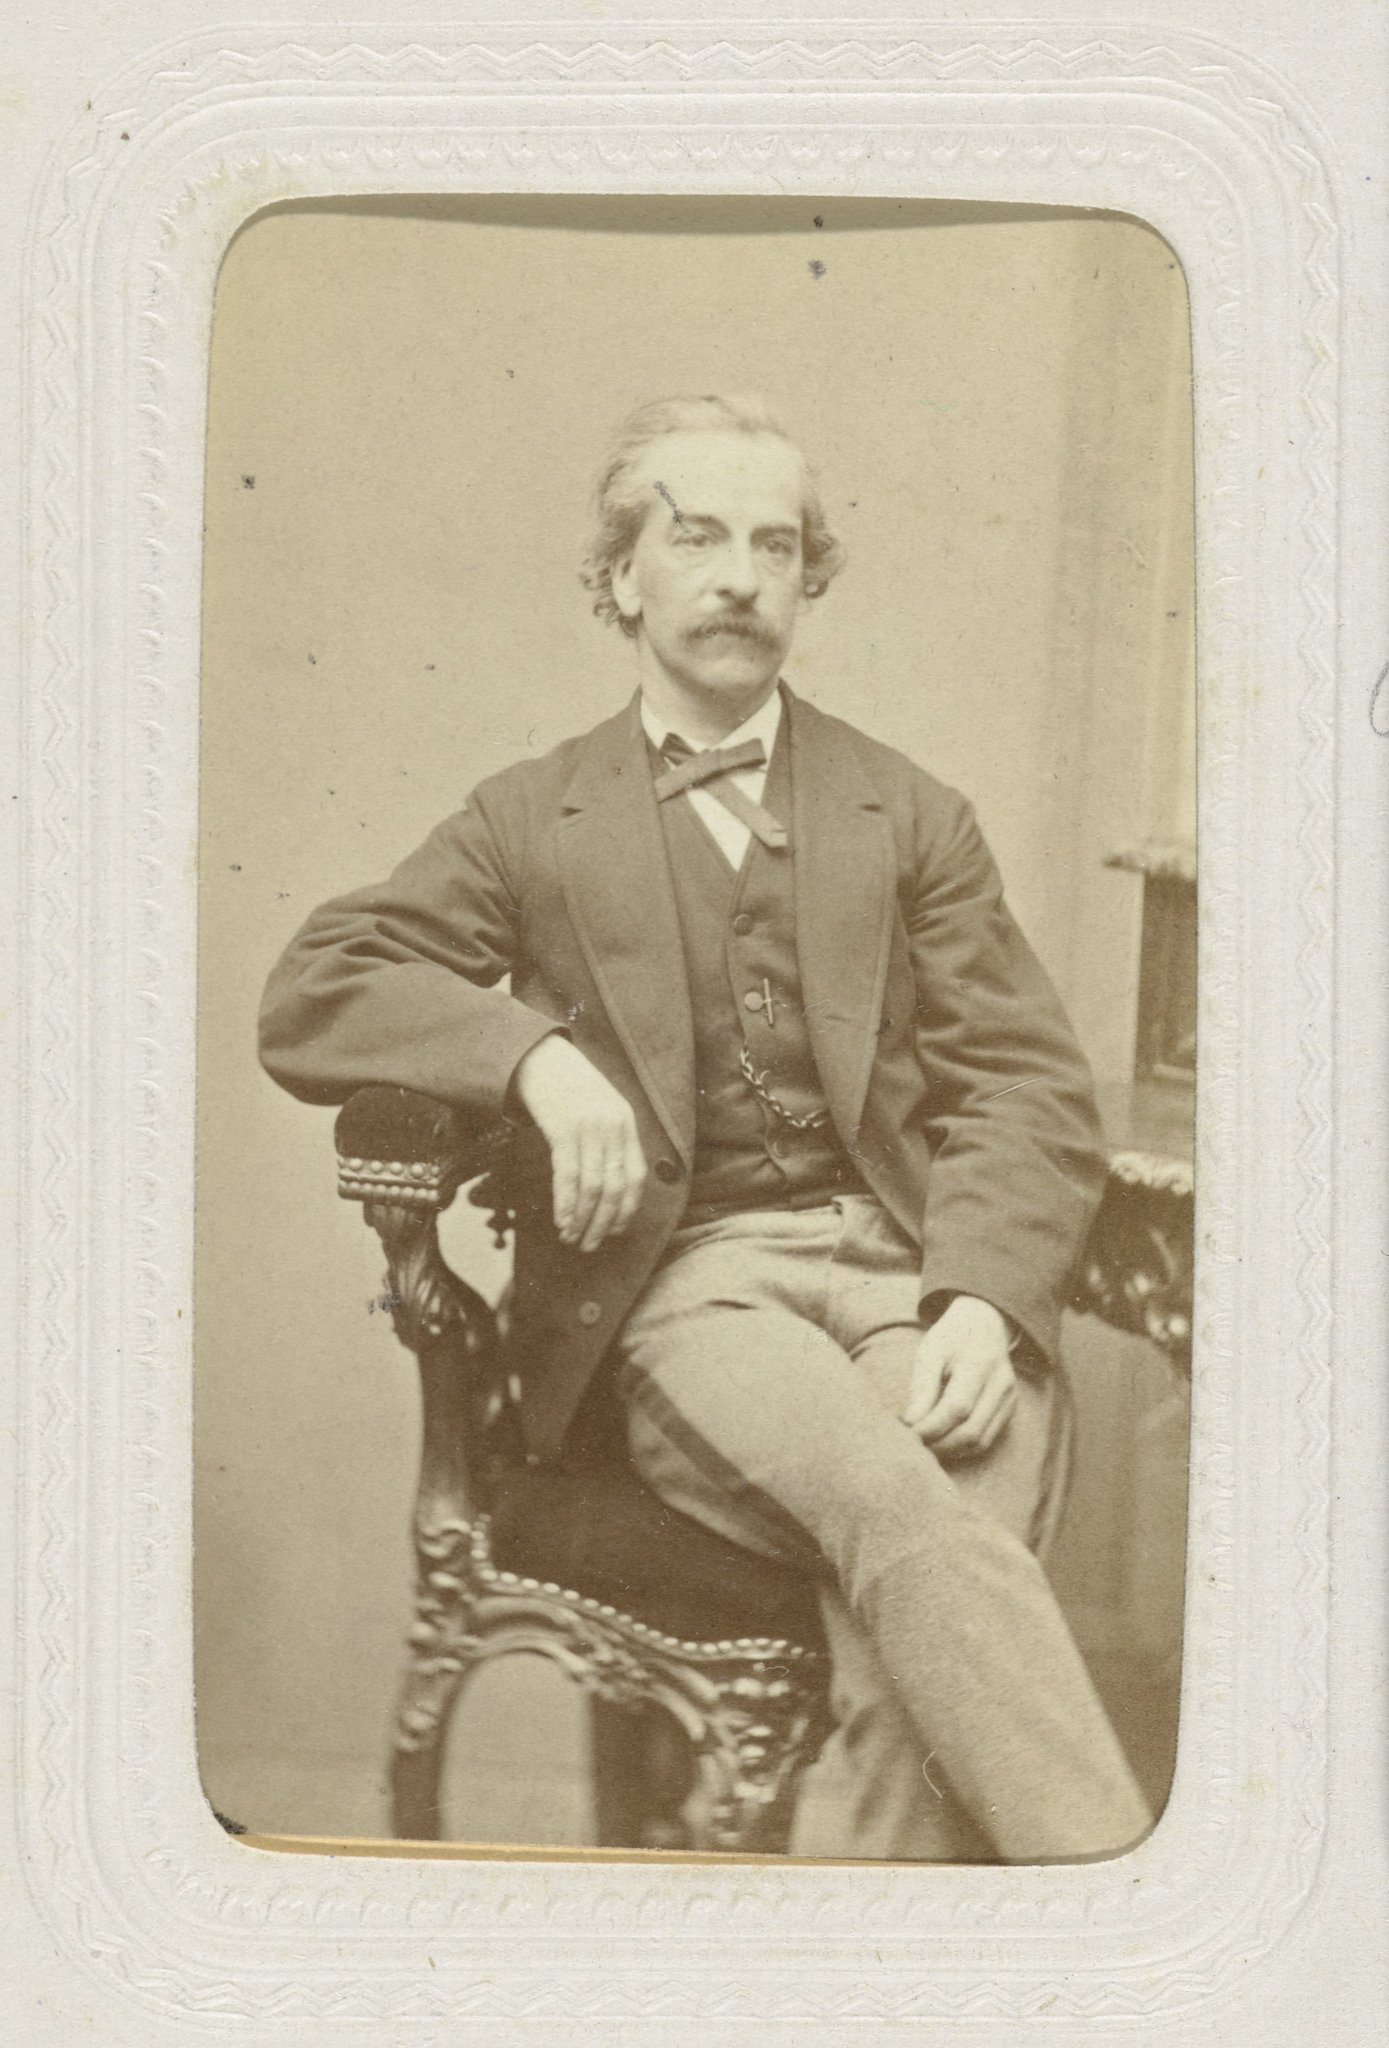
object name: carte de visite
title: Studioportret van een man met snor in een leunstoel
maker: albert greiner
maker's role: fotograaf, fotostudio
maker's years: 1833-1890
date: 1863-1870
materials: cardboard, paper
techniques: albumen print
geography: amsterdam